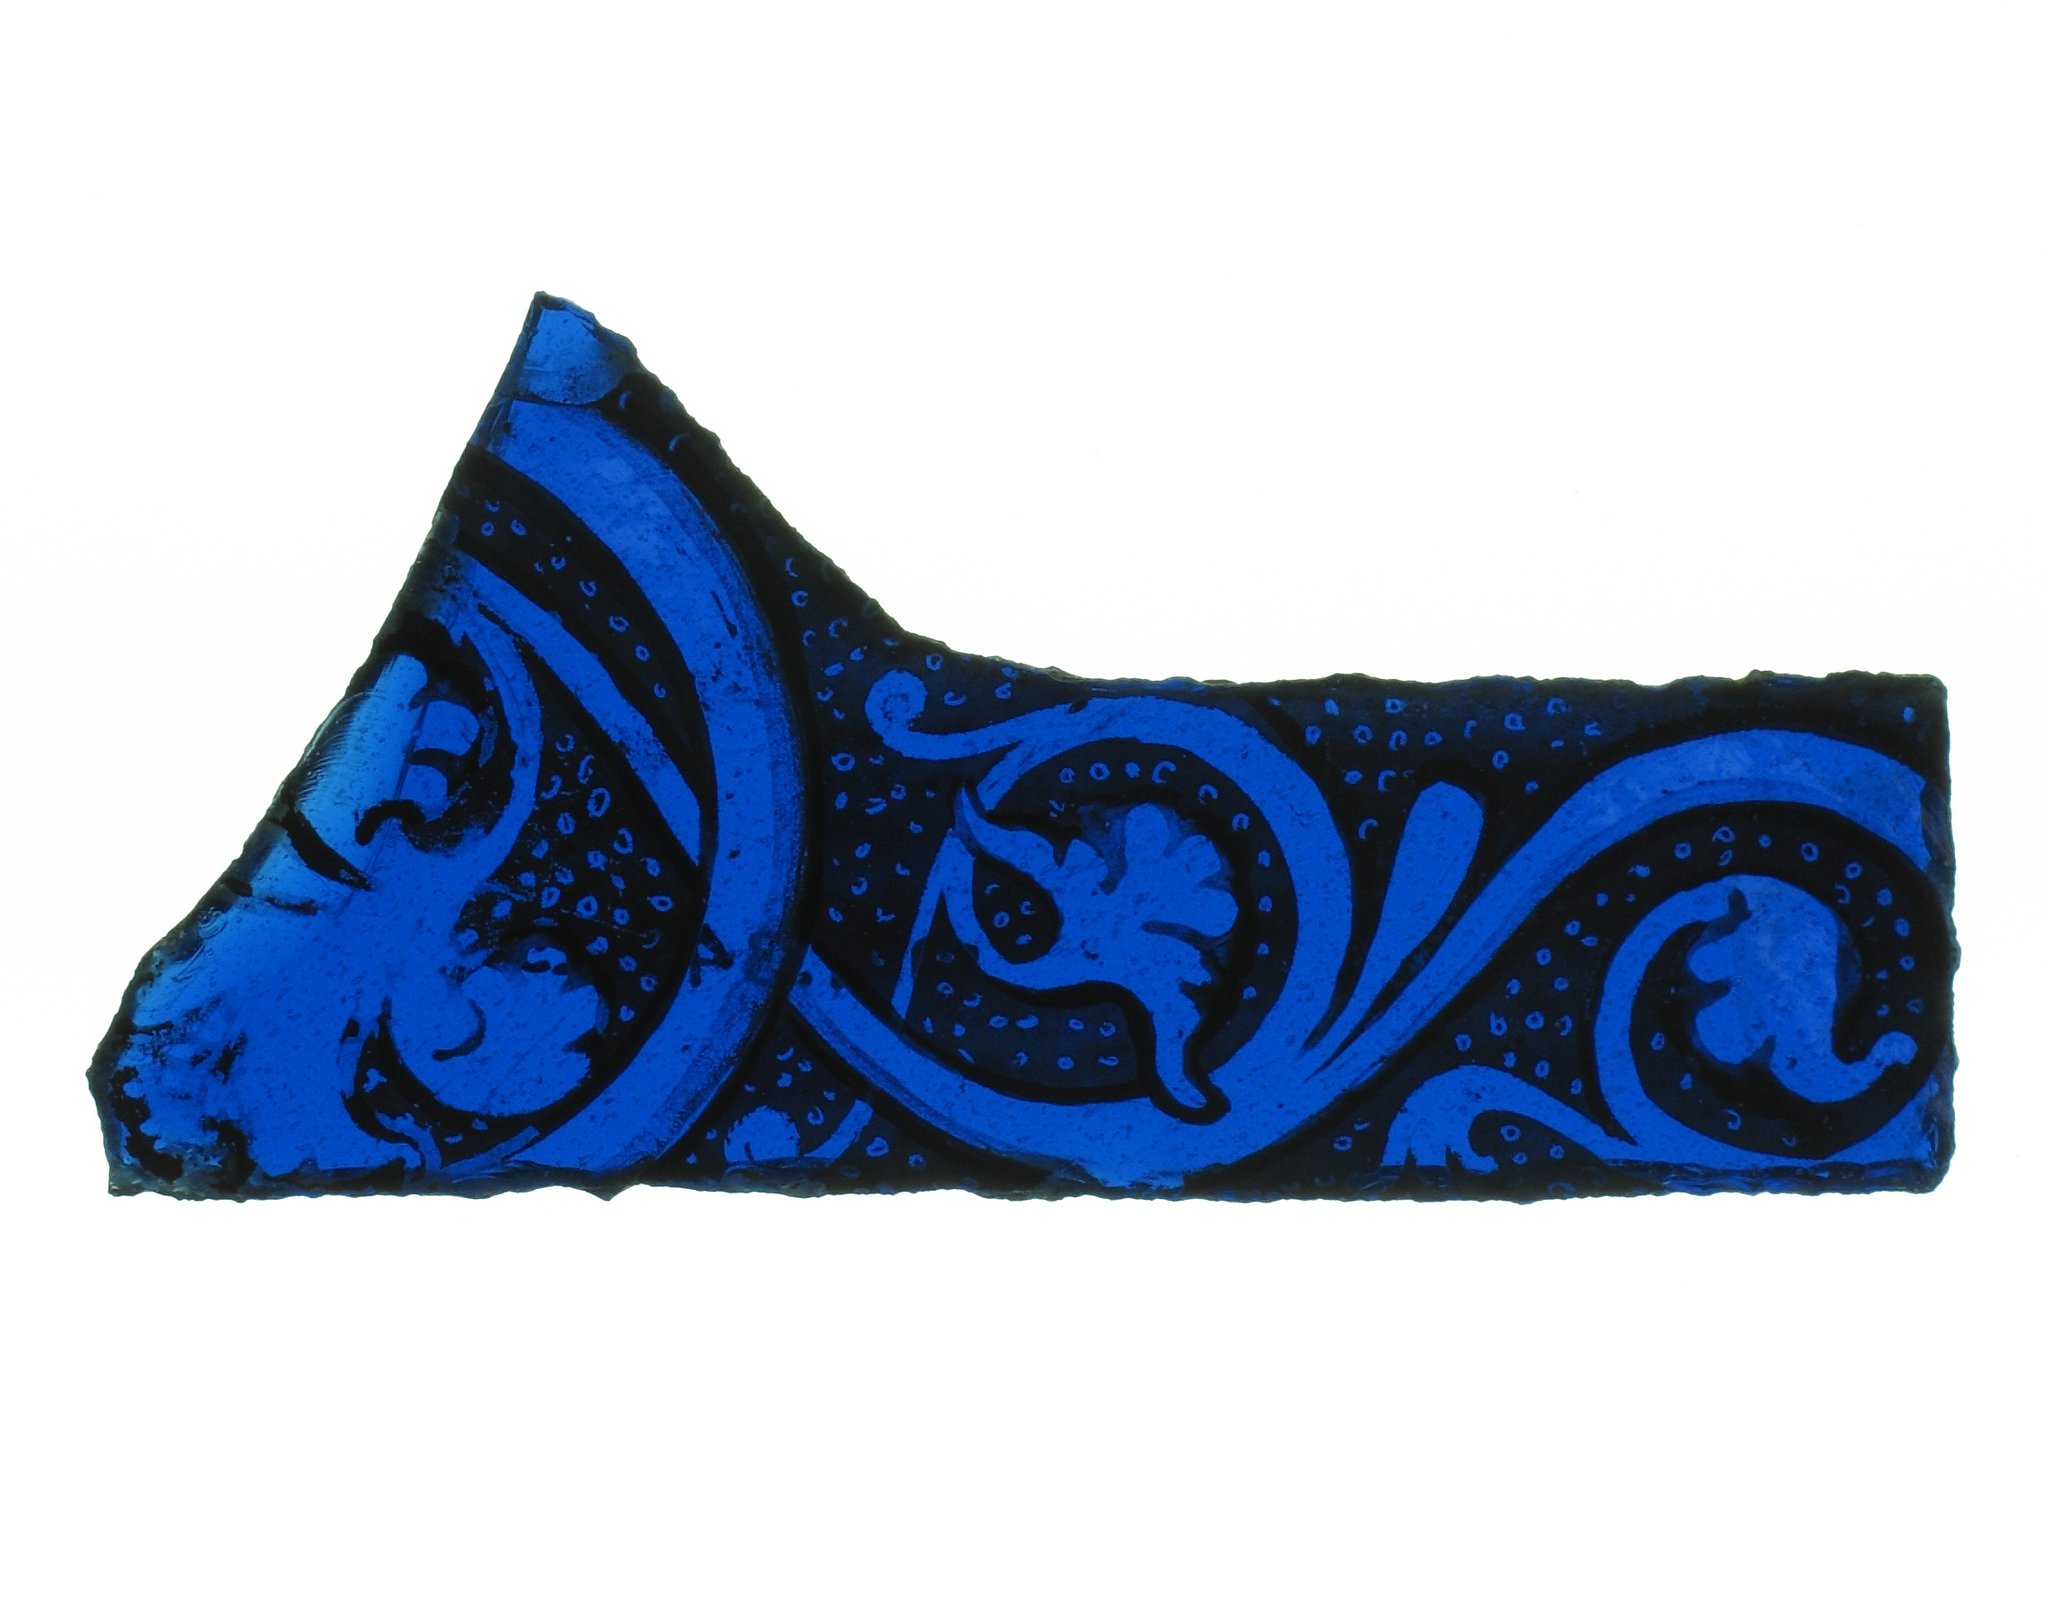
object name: fragment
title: Glass Fragment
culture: french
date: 1101-1400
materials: glass, metal, paint